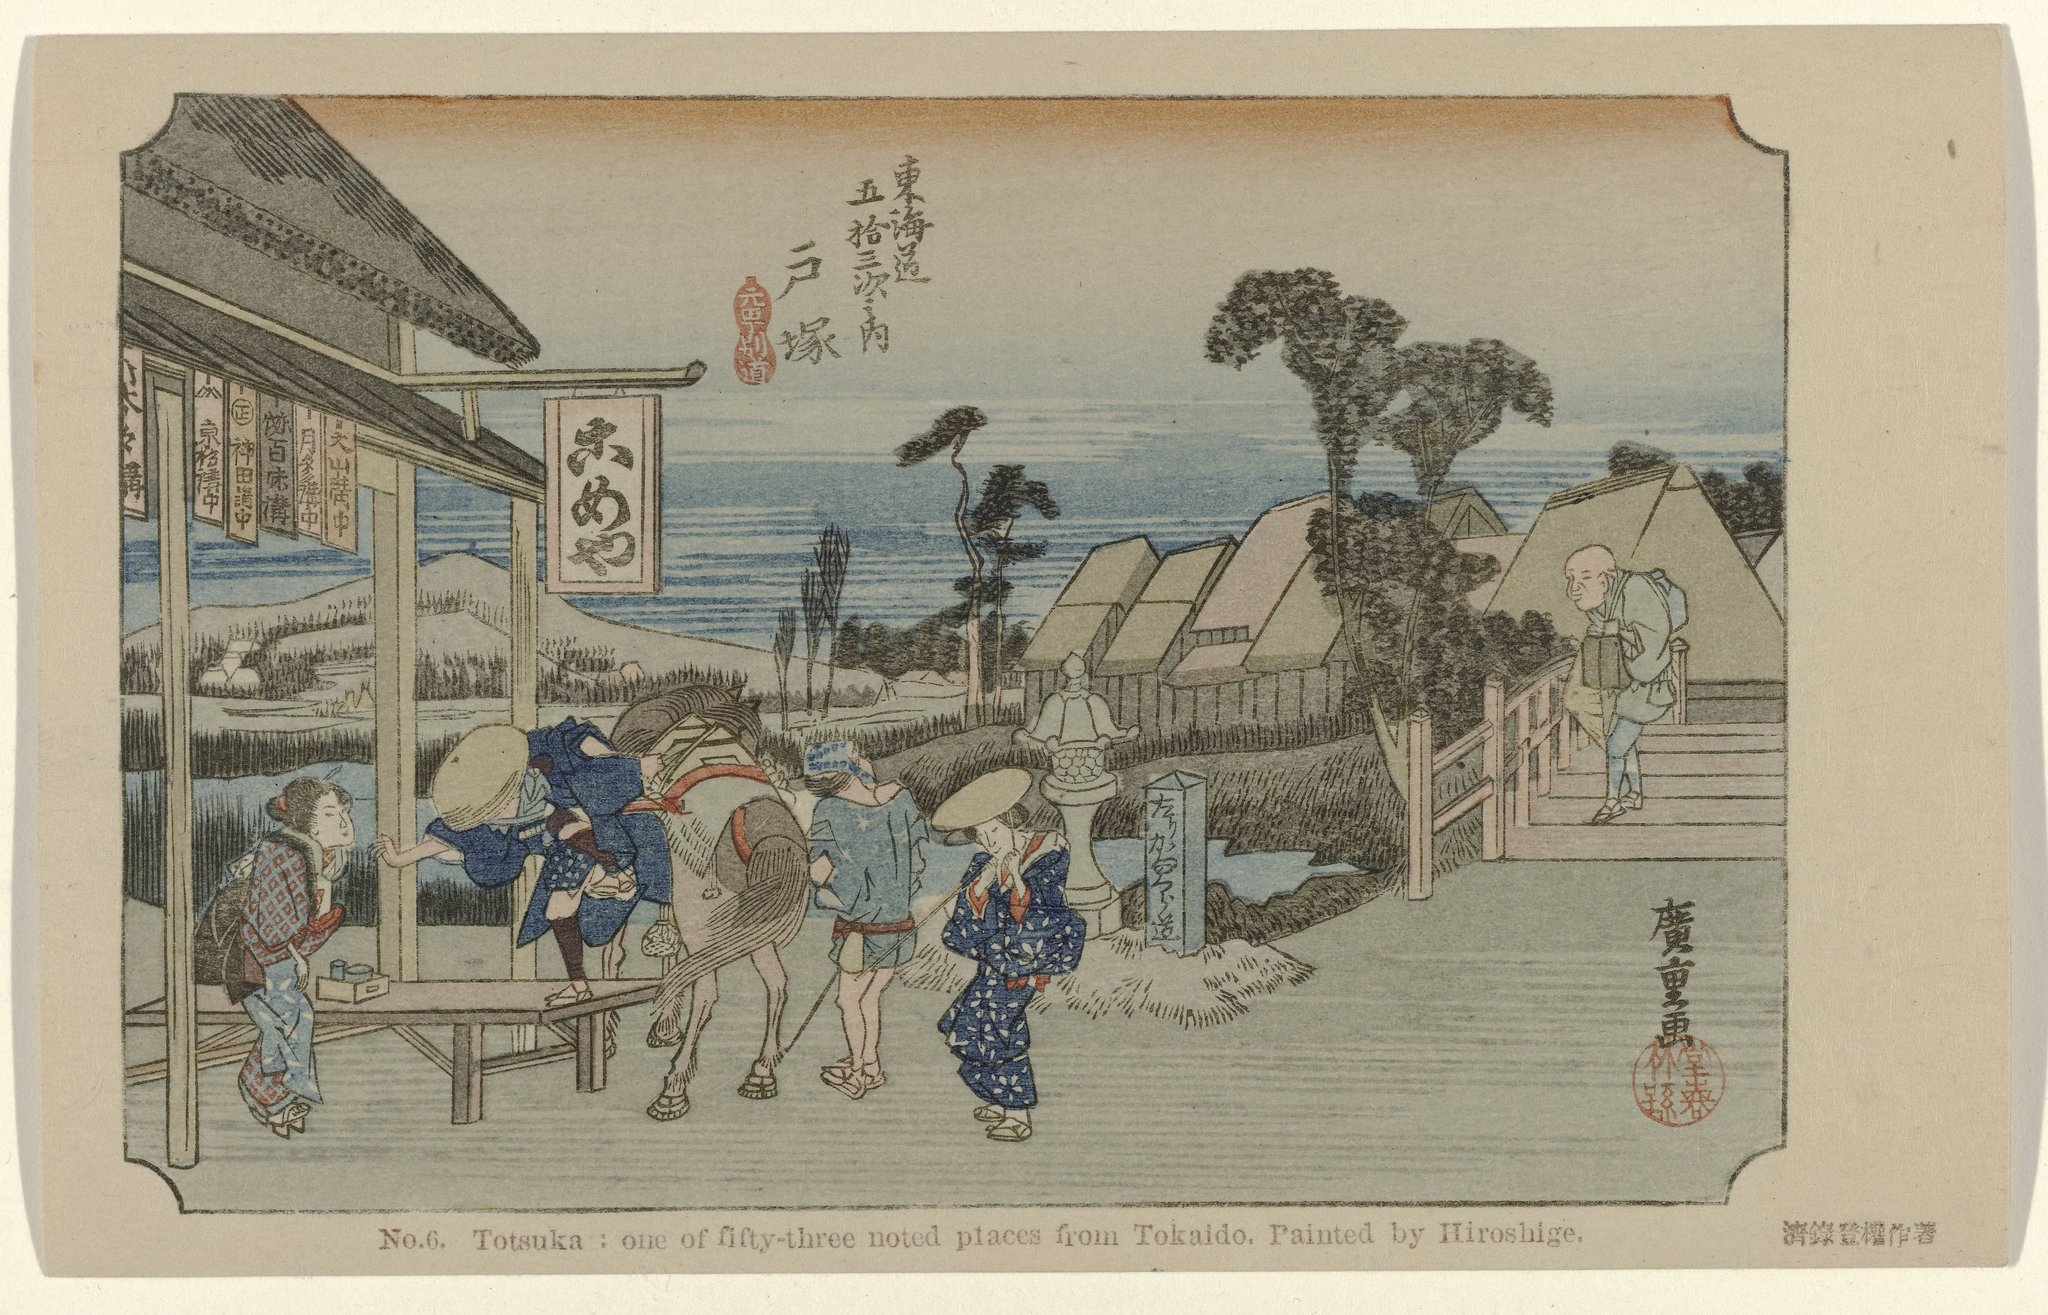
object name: ansichtkaart, prentbriefkaart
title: No. 6. Totsuka: one of the fifty-three noted places from Tokaido. Painted by Hiroshige.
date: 1906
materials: cardboard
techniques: woodcut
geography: japan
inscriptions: date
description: Een man stijgt van zijn paard af voor de deur van een theehuis, waar een serveester hem opwacht.